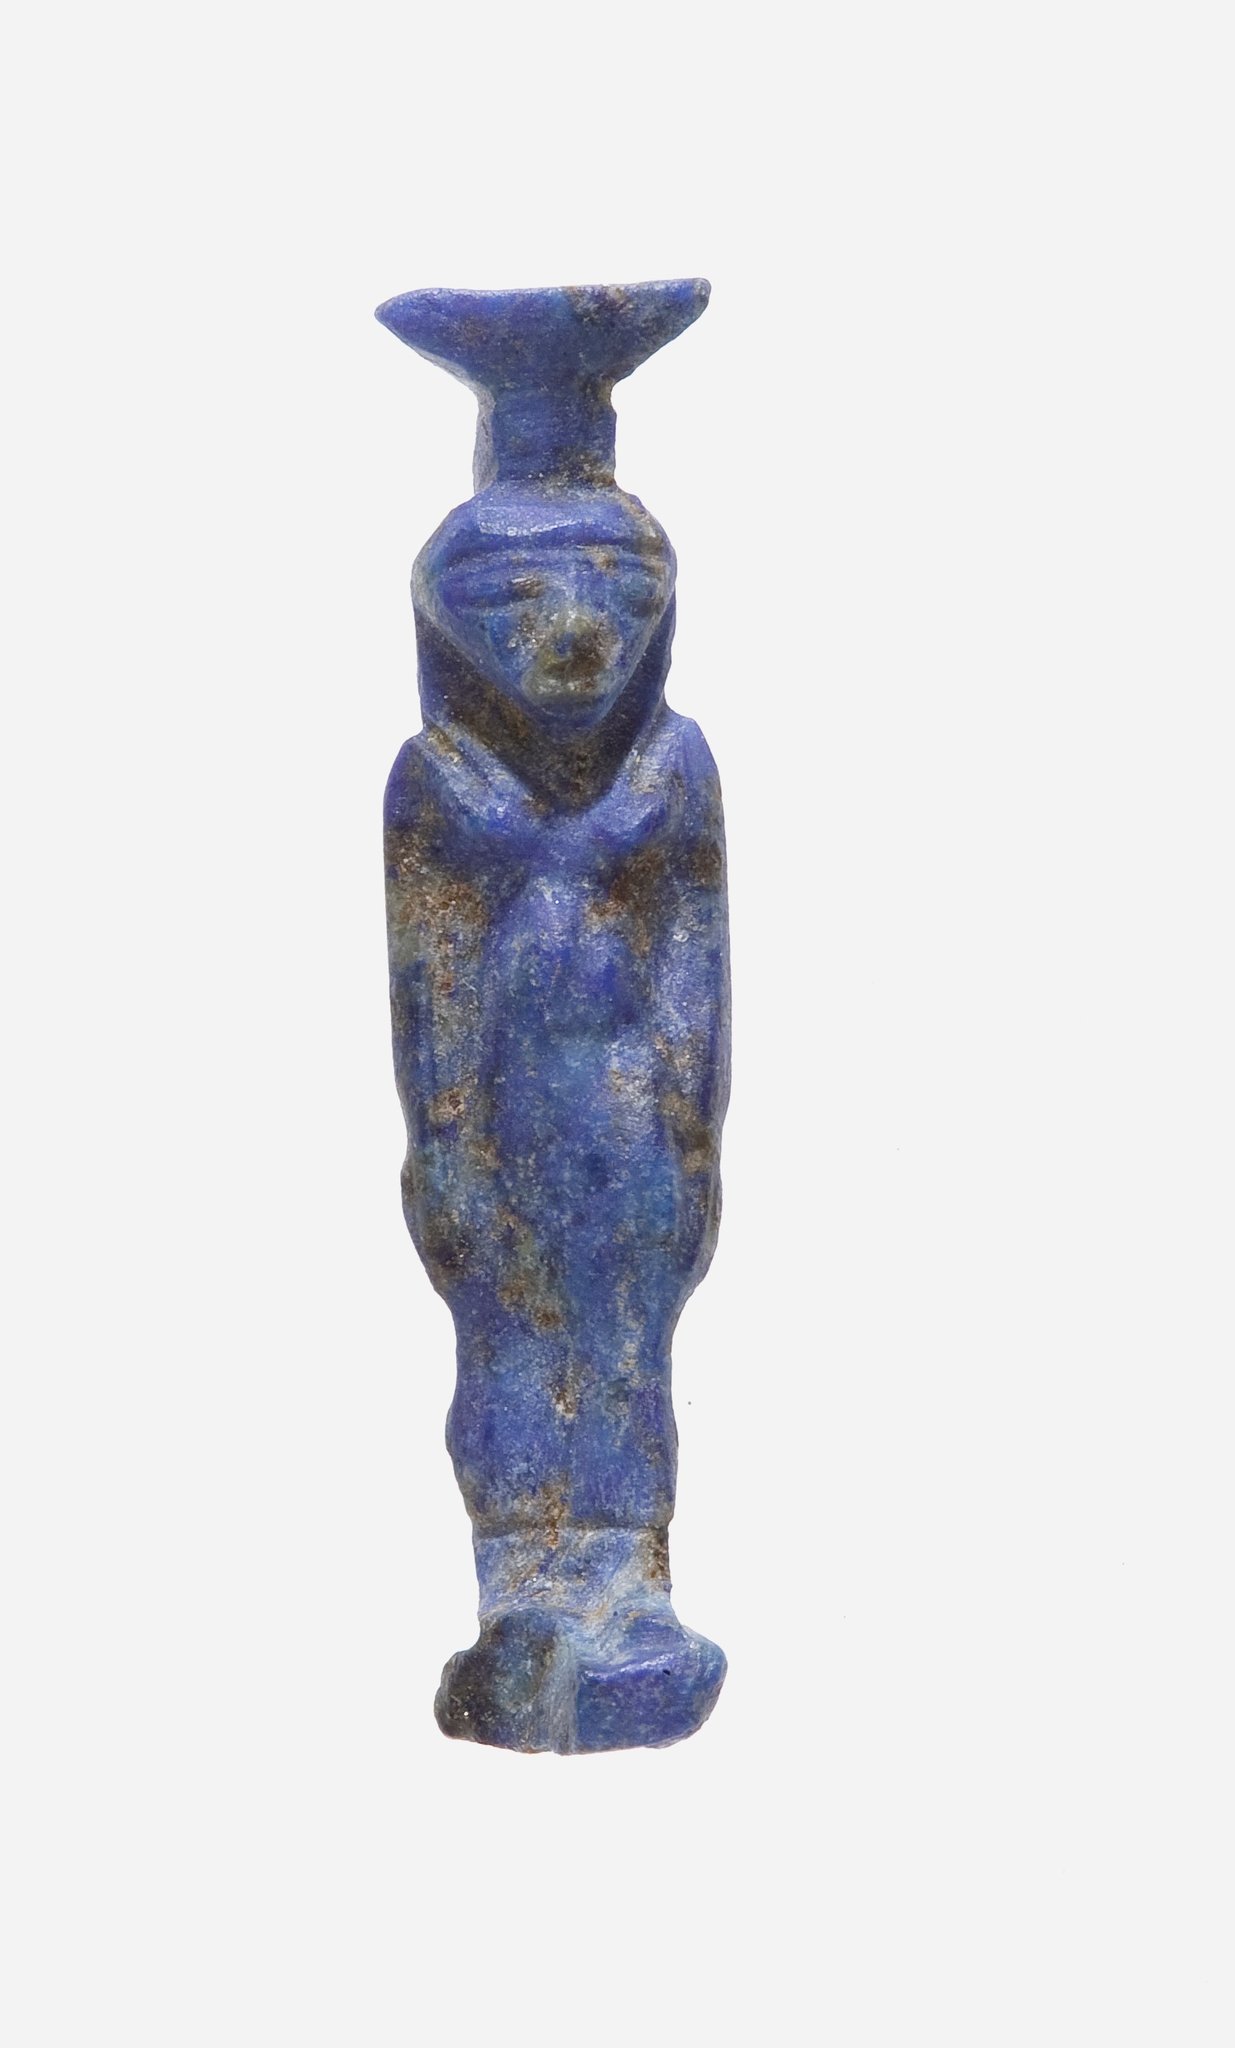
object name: amulet, nephthys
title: Nephthys Amulet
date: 664-332 BCE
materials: lapis lazuli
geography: egypt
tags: goddess